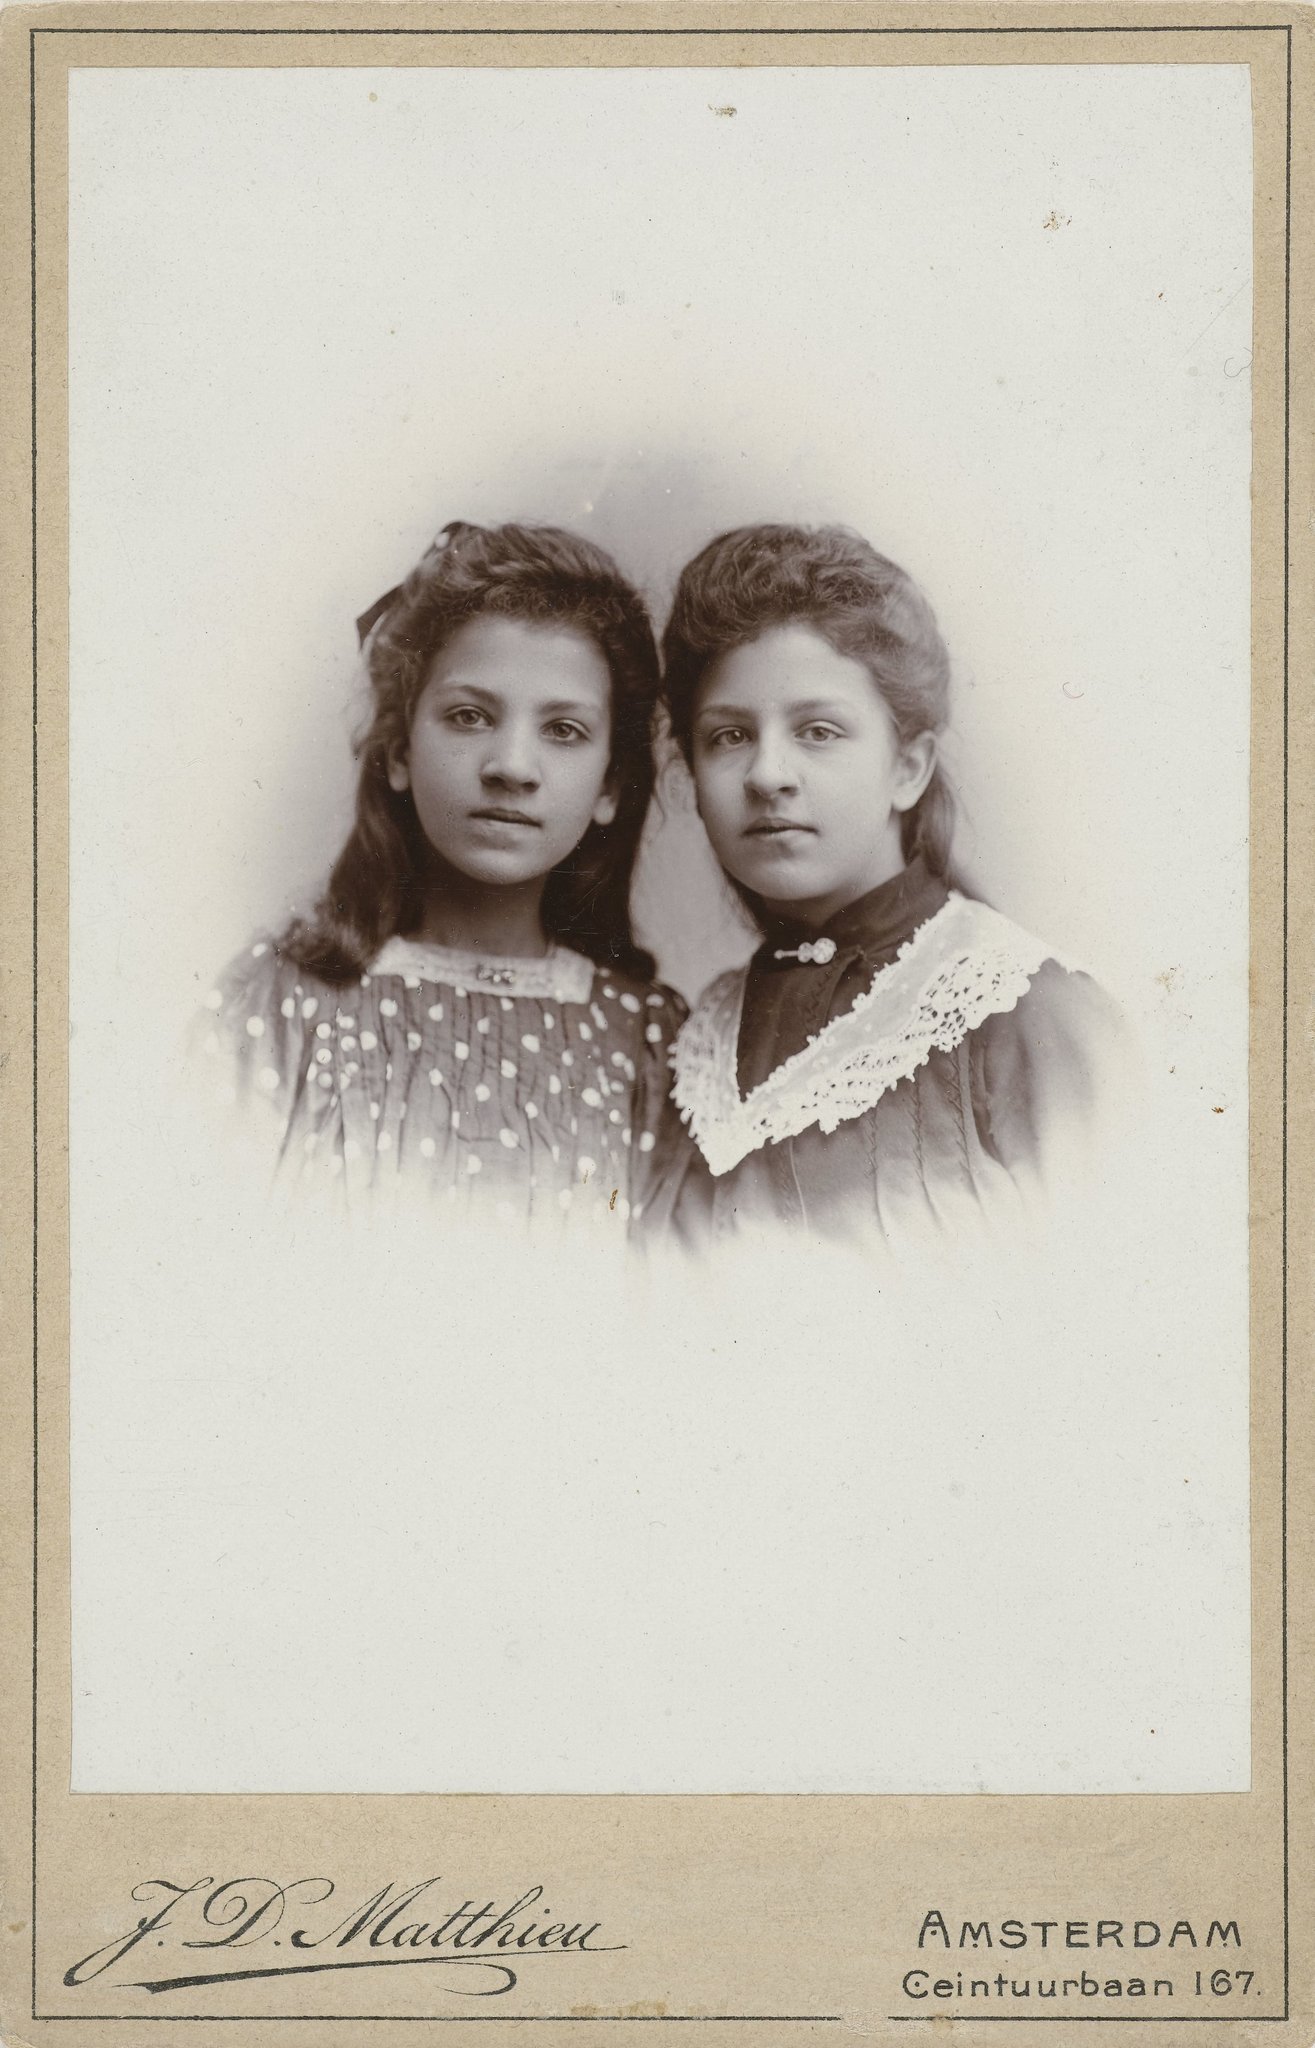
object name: photograph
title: Studioportret van twee meisjes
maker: jean daniel matthieu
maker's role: fotograaf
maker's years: 1865-1926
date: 1890-1920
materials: cardboard, photographic support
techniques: gelatin silver print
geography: amsterdam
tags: chest, bust - aa - female human figure, amsterdam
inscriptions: name: ‘Fotografie Artistique J.D. Matthieu Amsterdam Ceintuurbaan 167 Atelier parterre Specialiteit in vergrotingen’